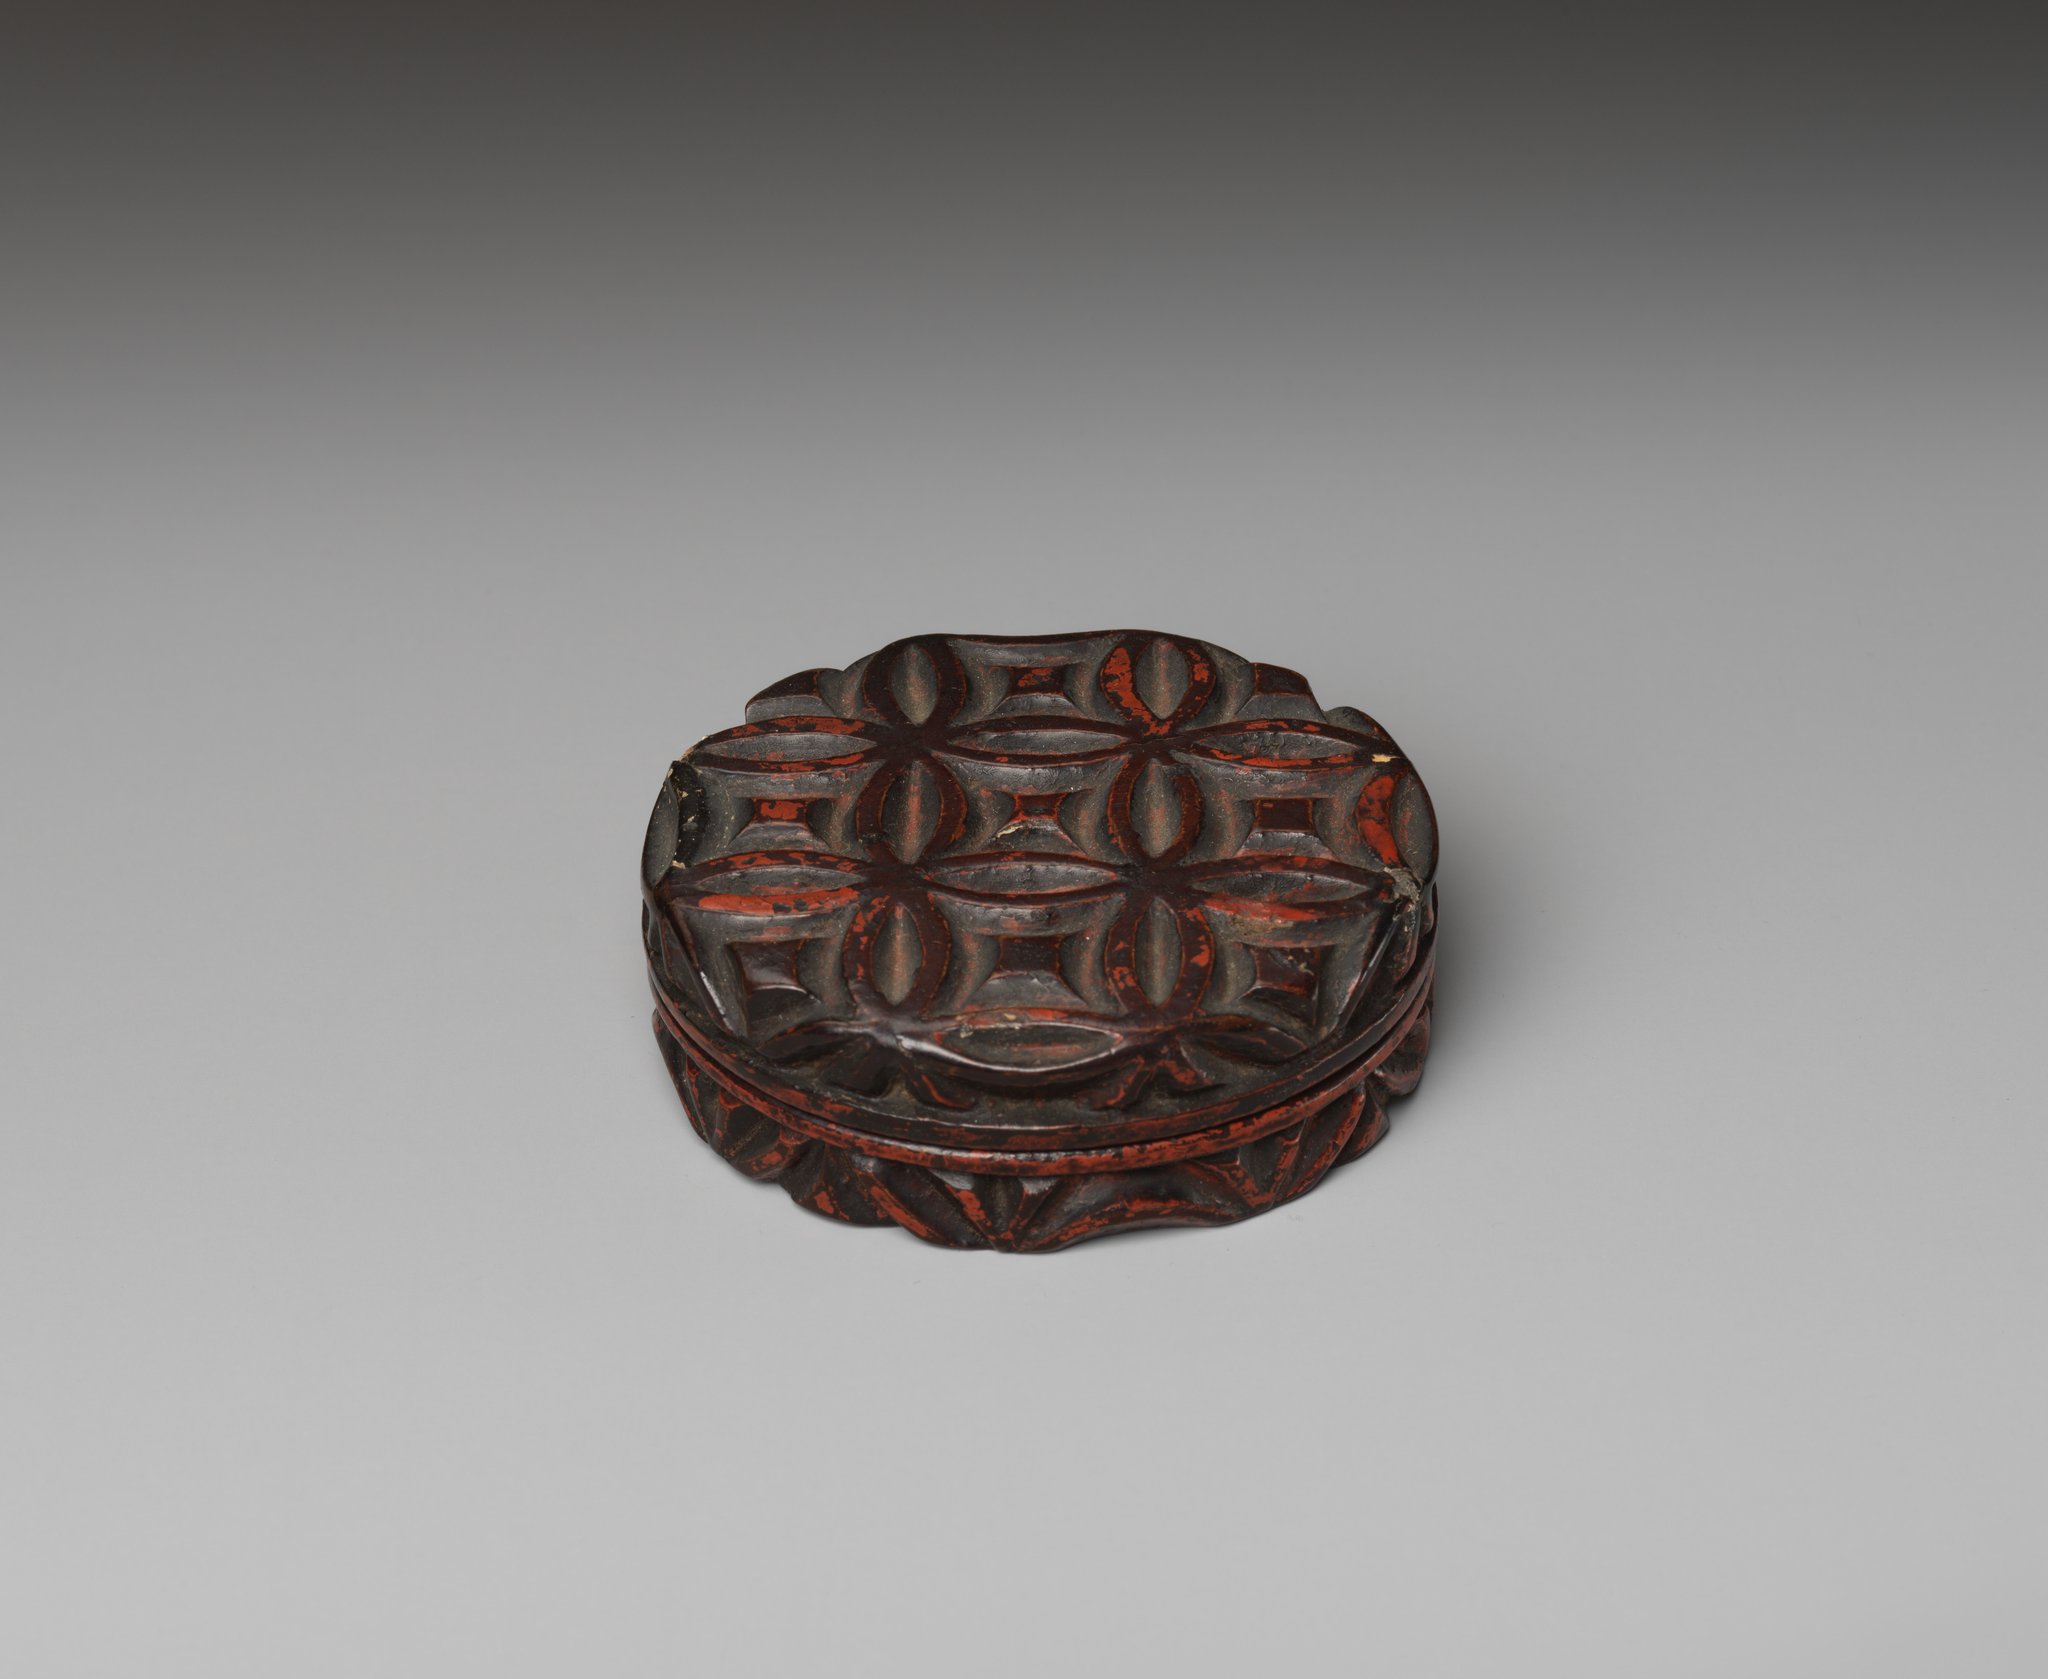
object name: box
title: Incense Box (Kōgō) with Interlinked Circles (Shippō) Pattern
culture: japanese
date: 1601-1633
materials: lacquer, wood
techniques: carving